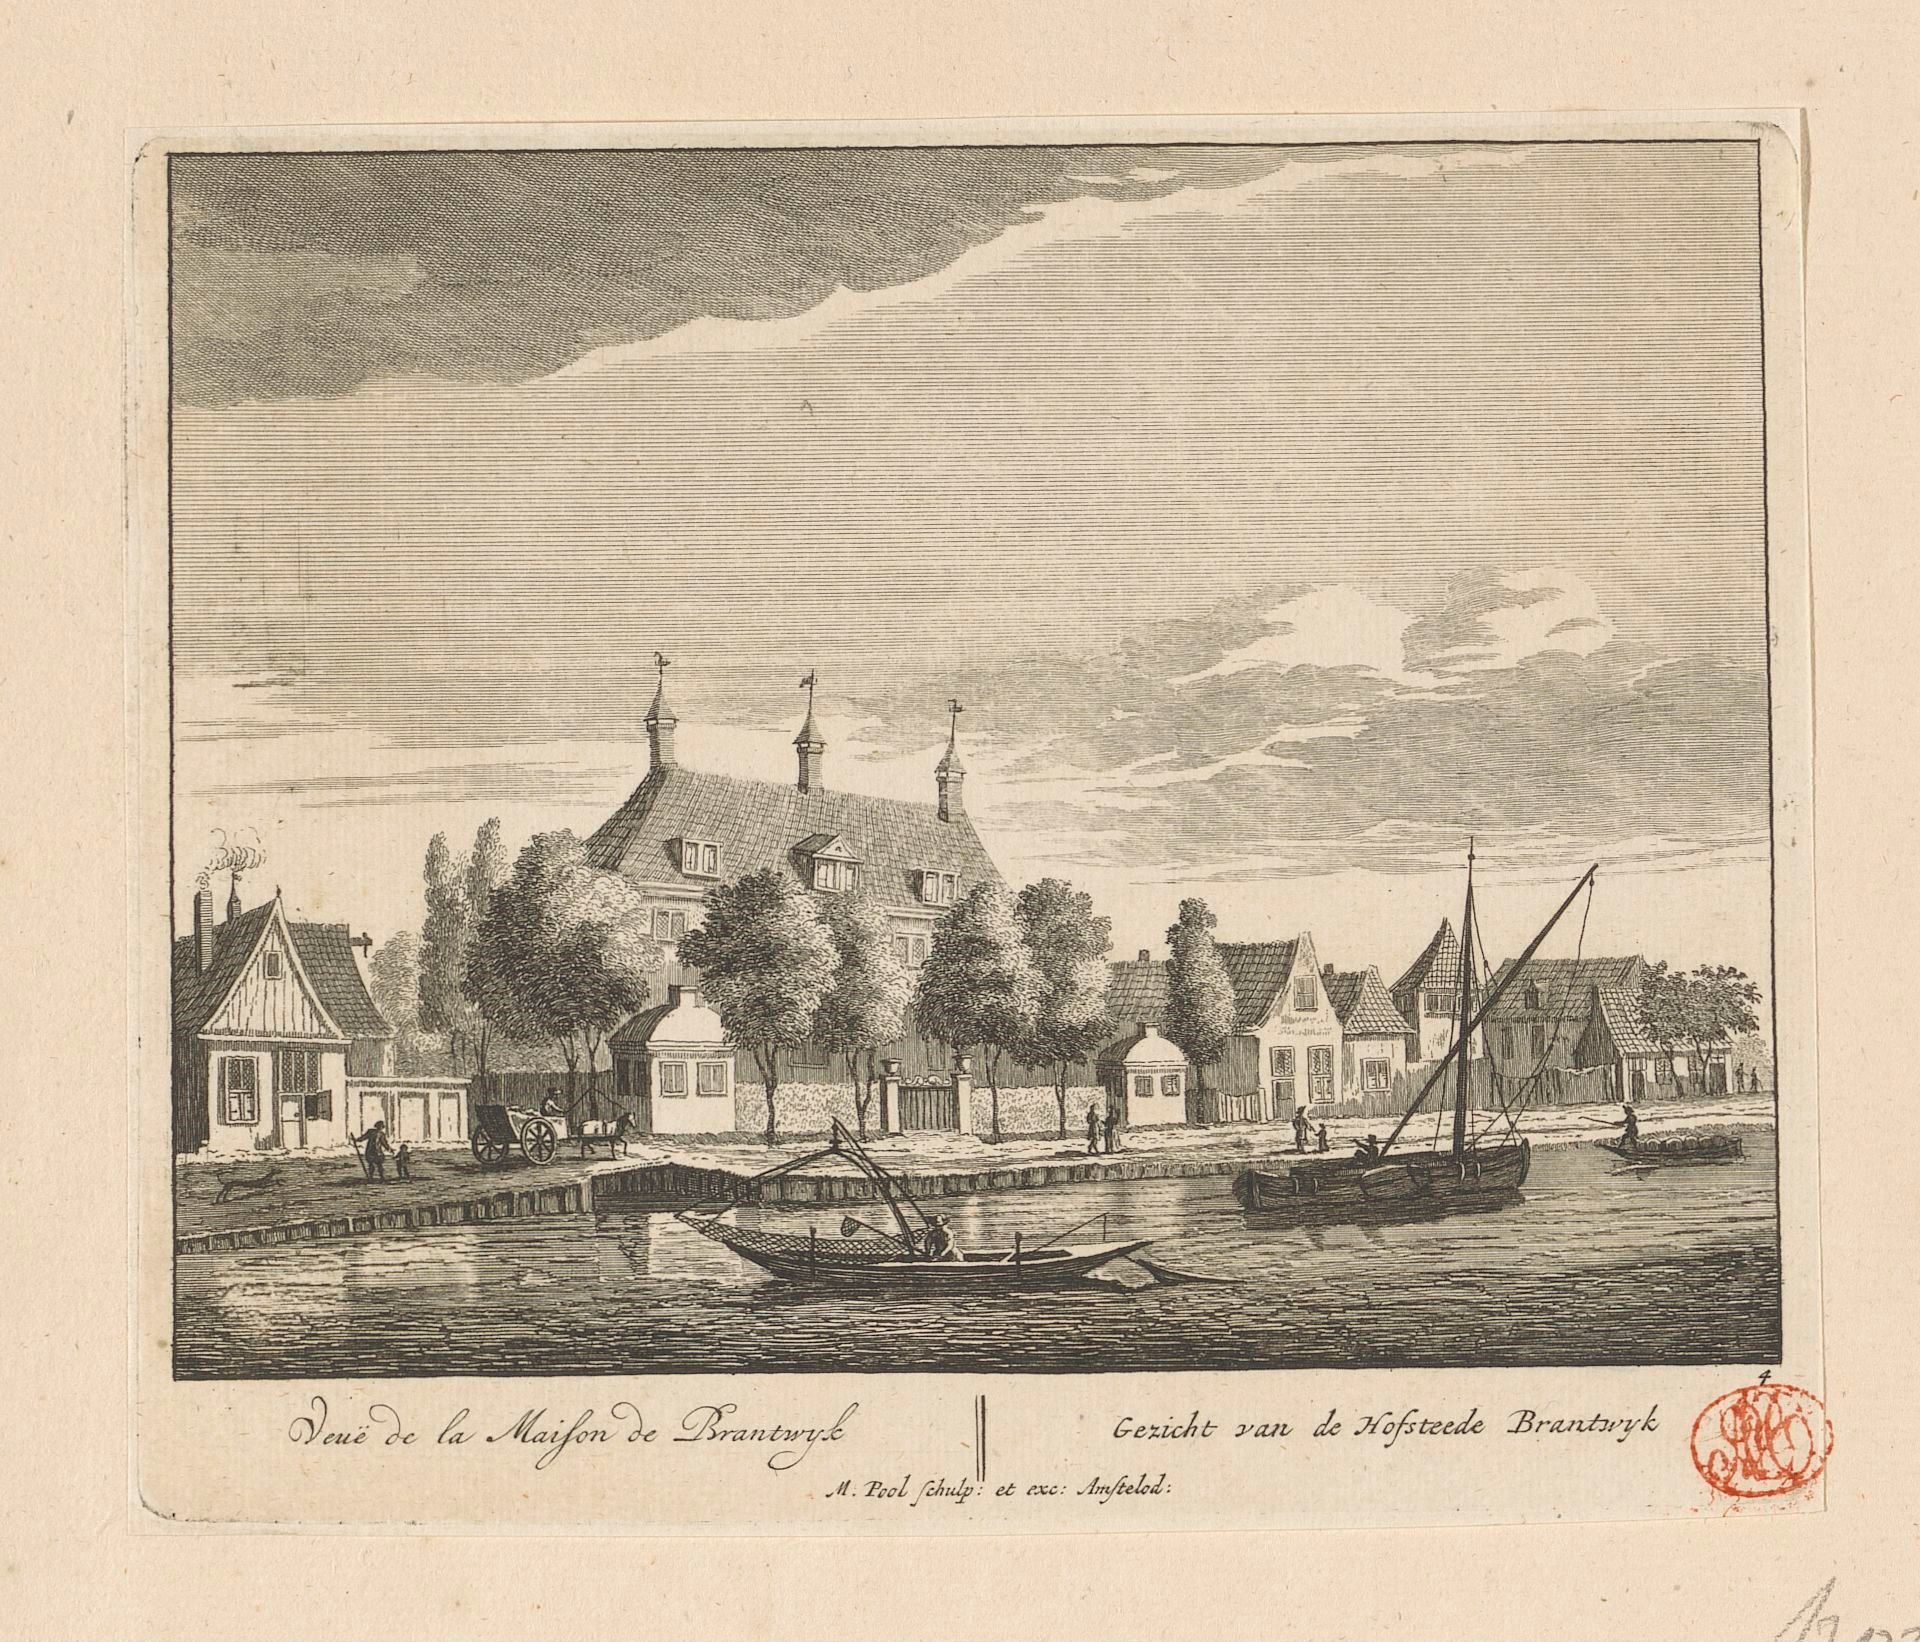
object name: print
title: Gezicht van de hofsteede Brantwyk / Veuë de la maison de Brantwyk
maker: matthijs pool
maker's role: print maker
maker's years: 1676-1740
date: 1708-1740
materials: paper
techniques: engraving, etching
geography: amsterdam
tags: sailing-ship, sailing-boat, river, rowing-boat, canoe, etc.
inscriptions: collector's mark: Lugt 195, collector's mark: Lugt 2233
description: Prent gebruikt in: Pool, Matthijs. Verscheyde gesigten van de vermaarde rievier de buyten Amstel van de stadt Amsterdam, tot het dorp Ouwerkerk (…) / Plusieurs veuës et perspectives de la fameuse riviére de Buyten-Amstel depuis Amsterdam jusqu'au village d'Ouwerkerk (…). Amsterdam: Matthijs Pool, z.j. [1708-1740].